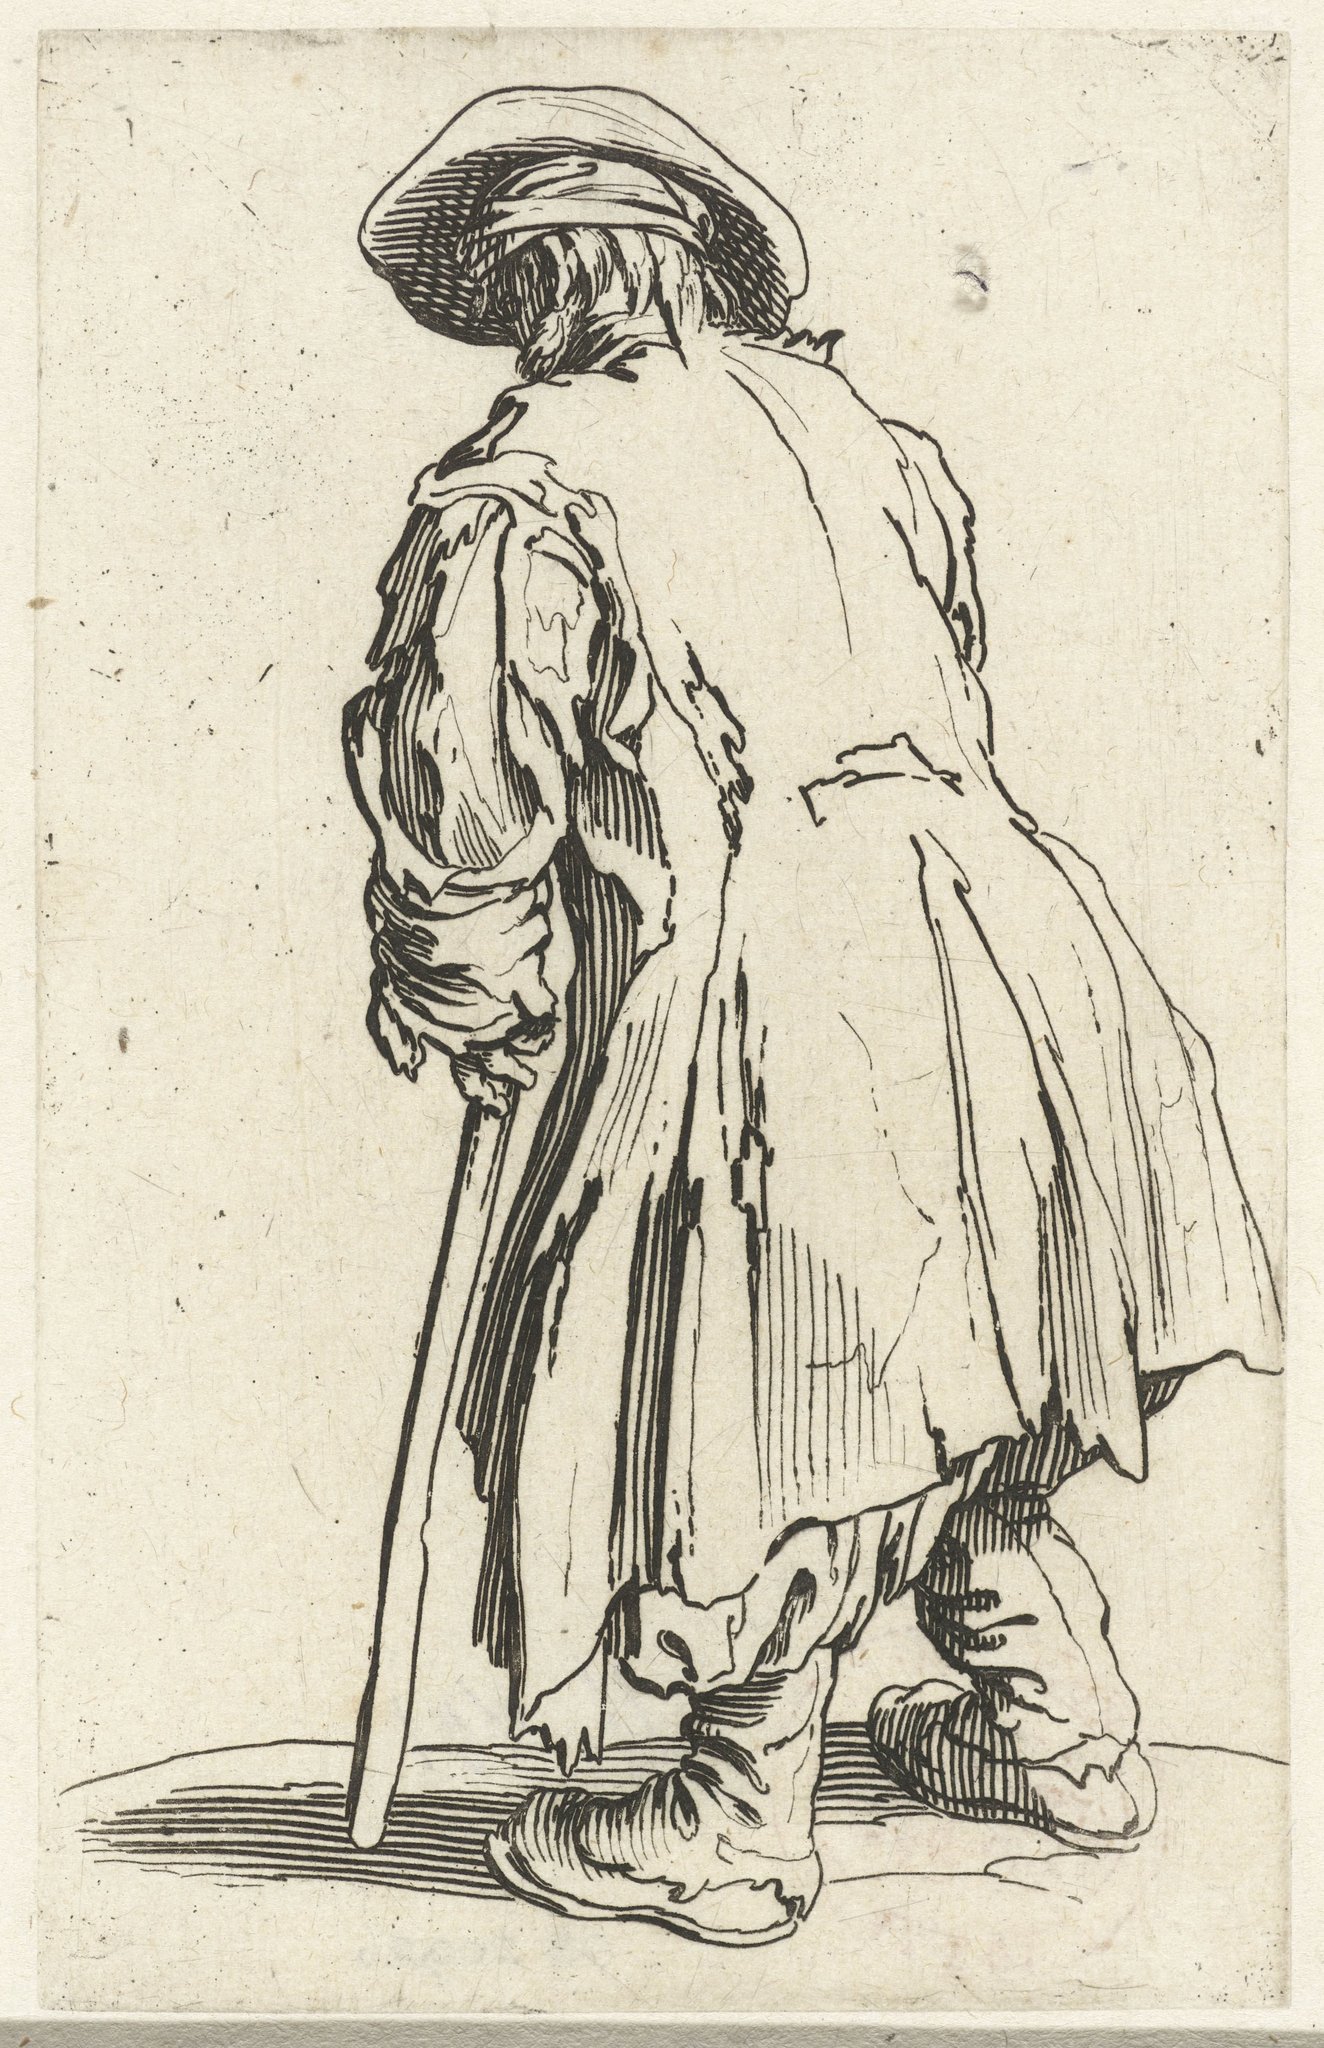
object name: print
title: Les Gueux / Les Mendiants / Les Baroni / Les Barons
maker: jacques callot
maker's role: draughtsman, print maker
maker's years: 1592-1635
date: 1622-1623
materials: paper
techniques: etching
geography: nancy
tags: walking-stick, staff, beggar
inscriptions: collector's mark: Lugt 240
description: Man, gekleed in lompen, op de rug gezien, steunend op een stok. Deze prent is onderdeel van een serie van 25 prenten met bedelaars en zwervers, zoals Callot die waarschijnlijk in Italië heeft gezien.